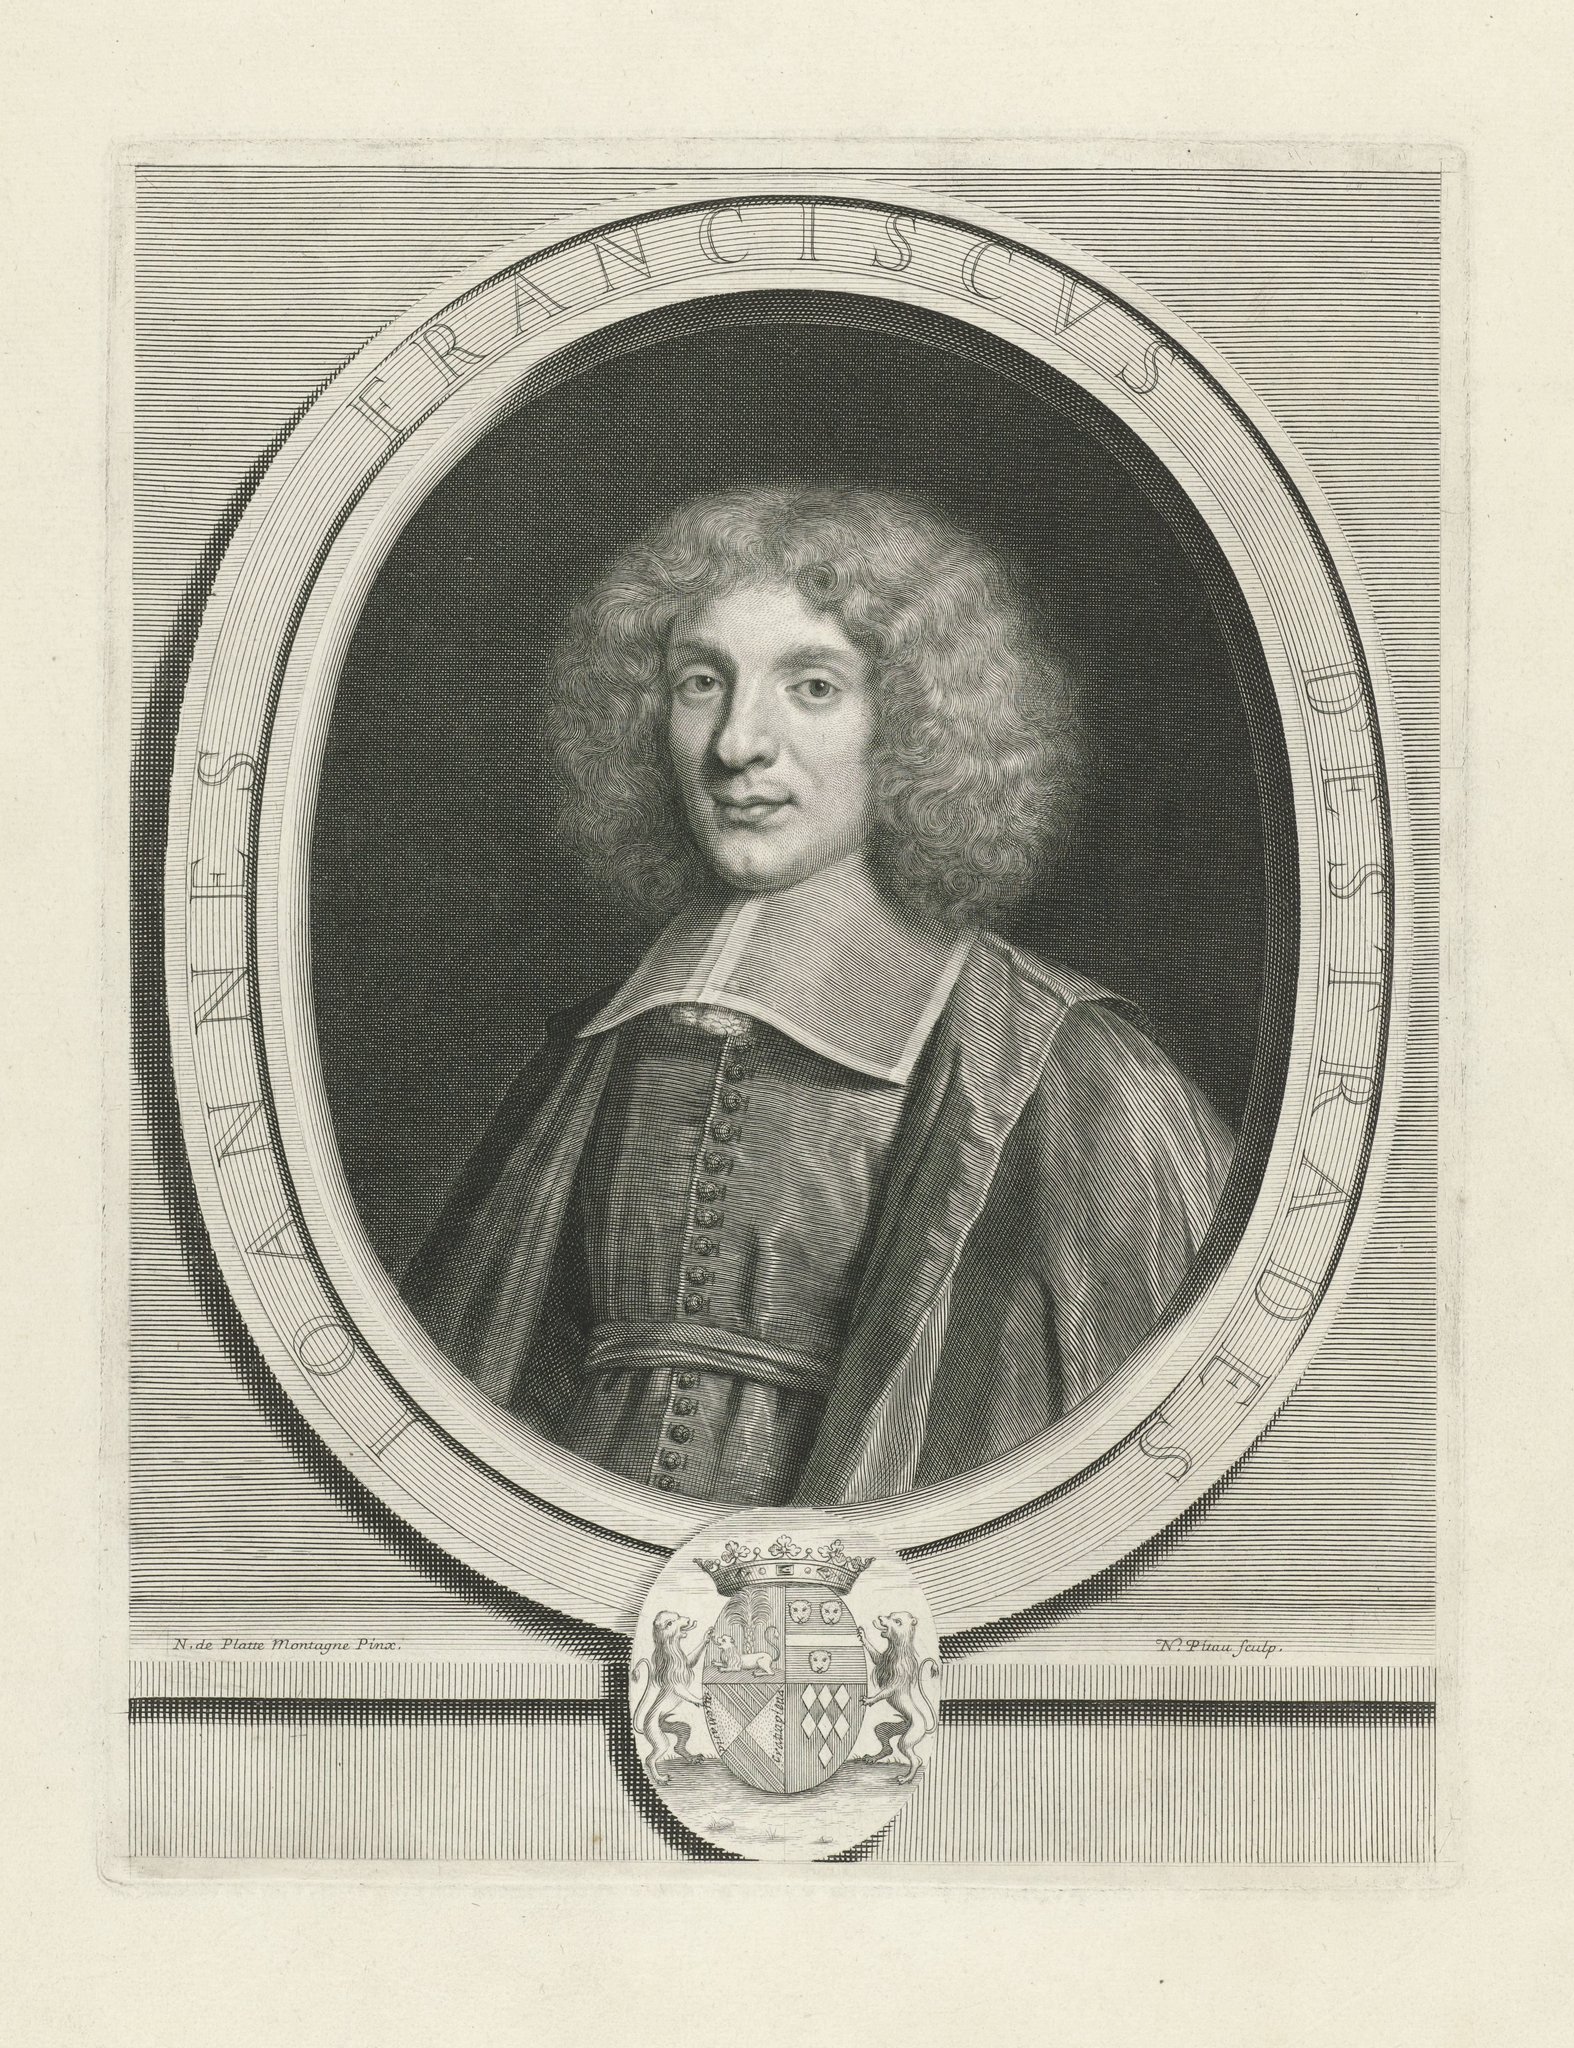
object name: print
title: Portret van Jean Francois d'Estrades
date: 1644-1671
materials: paper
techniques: engraving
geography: paris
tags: jean francois d' estrades, armorial bearing, heraldry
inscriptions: collector's mark: Lugt 2228